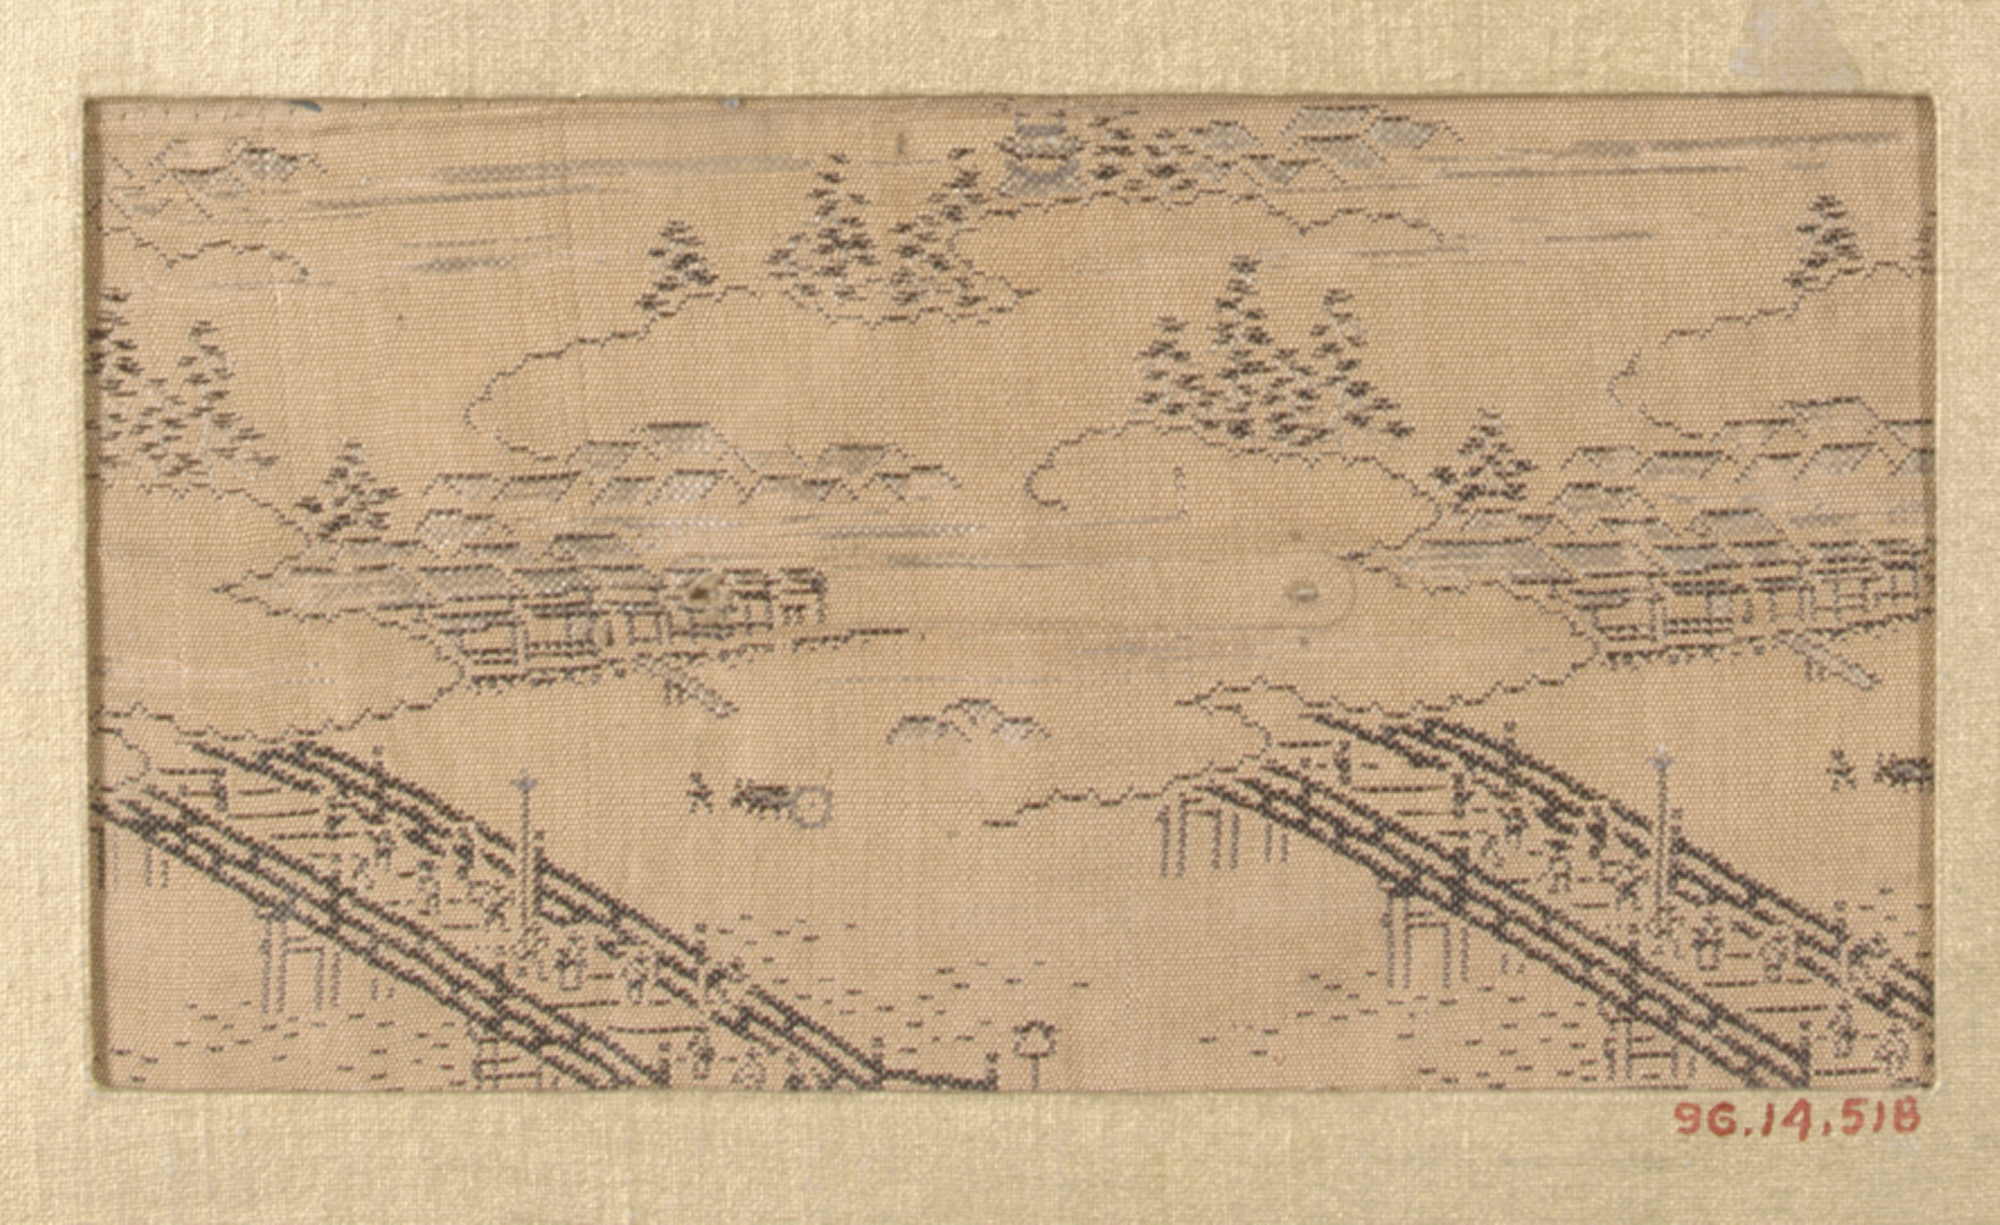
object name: piece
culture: japanese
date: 1701-1900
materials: silk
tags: bridges